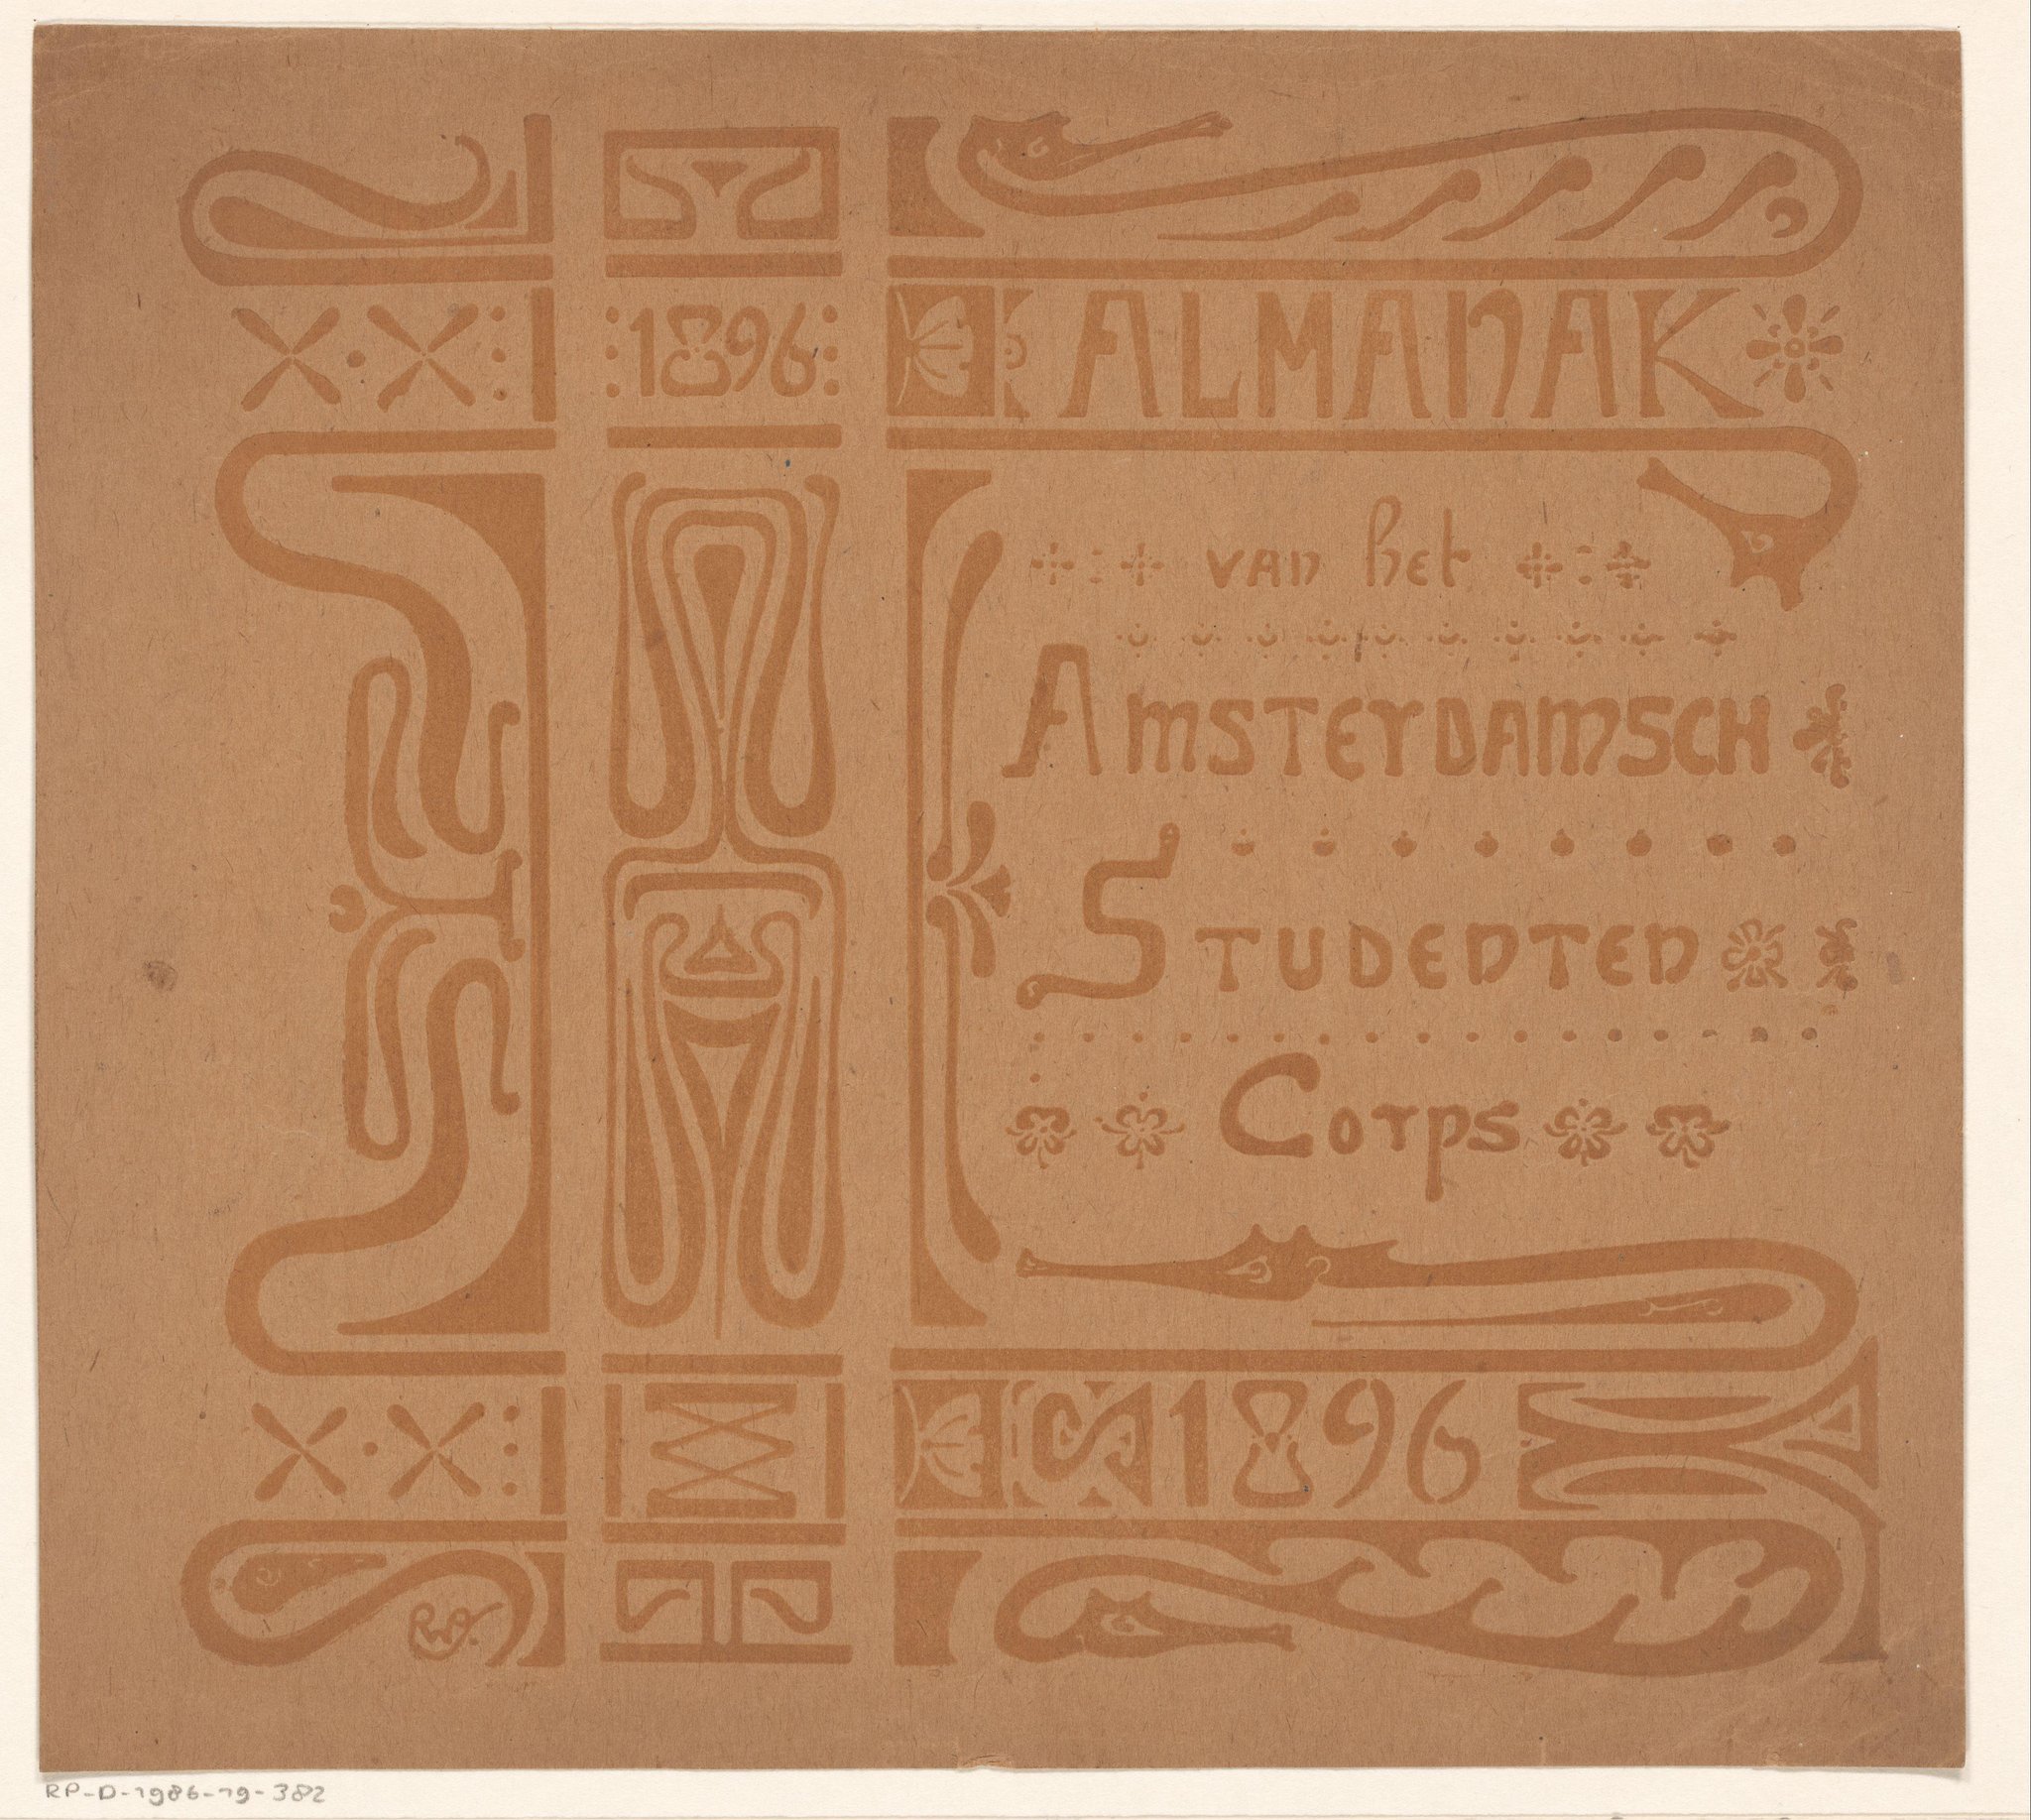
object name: print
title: Bandontwerp voor: Almanak van het Amsterdamsch Studenten Corps, 1896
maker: reinier willem petrus de vries (1874-1953)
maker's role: draughtsman, print maker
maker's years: 1874-1953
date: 1896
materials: paper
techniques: lithograph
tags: ornament ~ combination of straight and curved lines, flowers ~ ornament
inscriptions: collector's mark: ‘R:MVS.’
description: Bandontwerp voor: Almanak van het Amsterdamsch Studenten Corps. 66e jaargang. S.l.s.n., 1896.